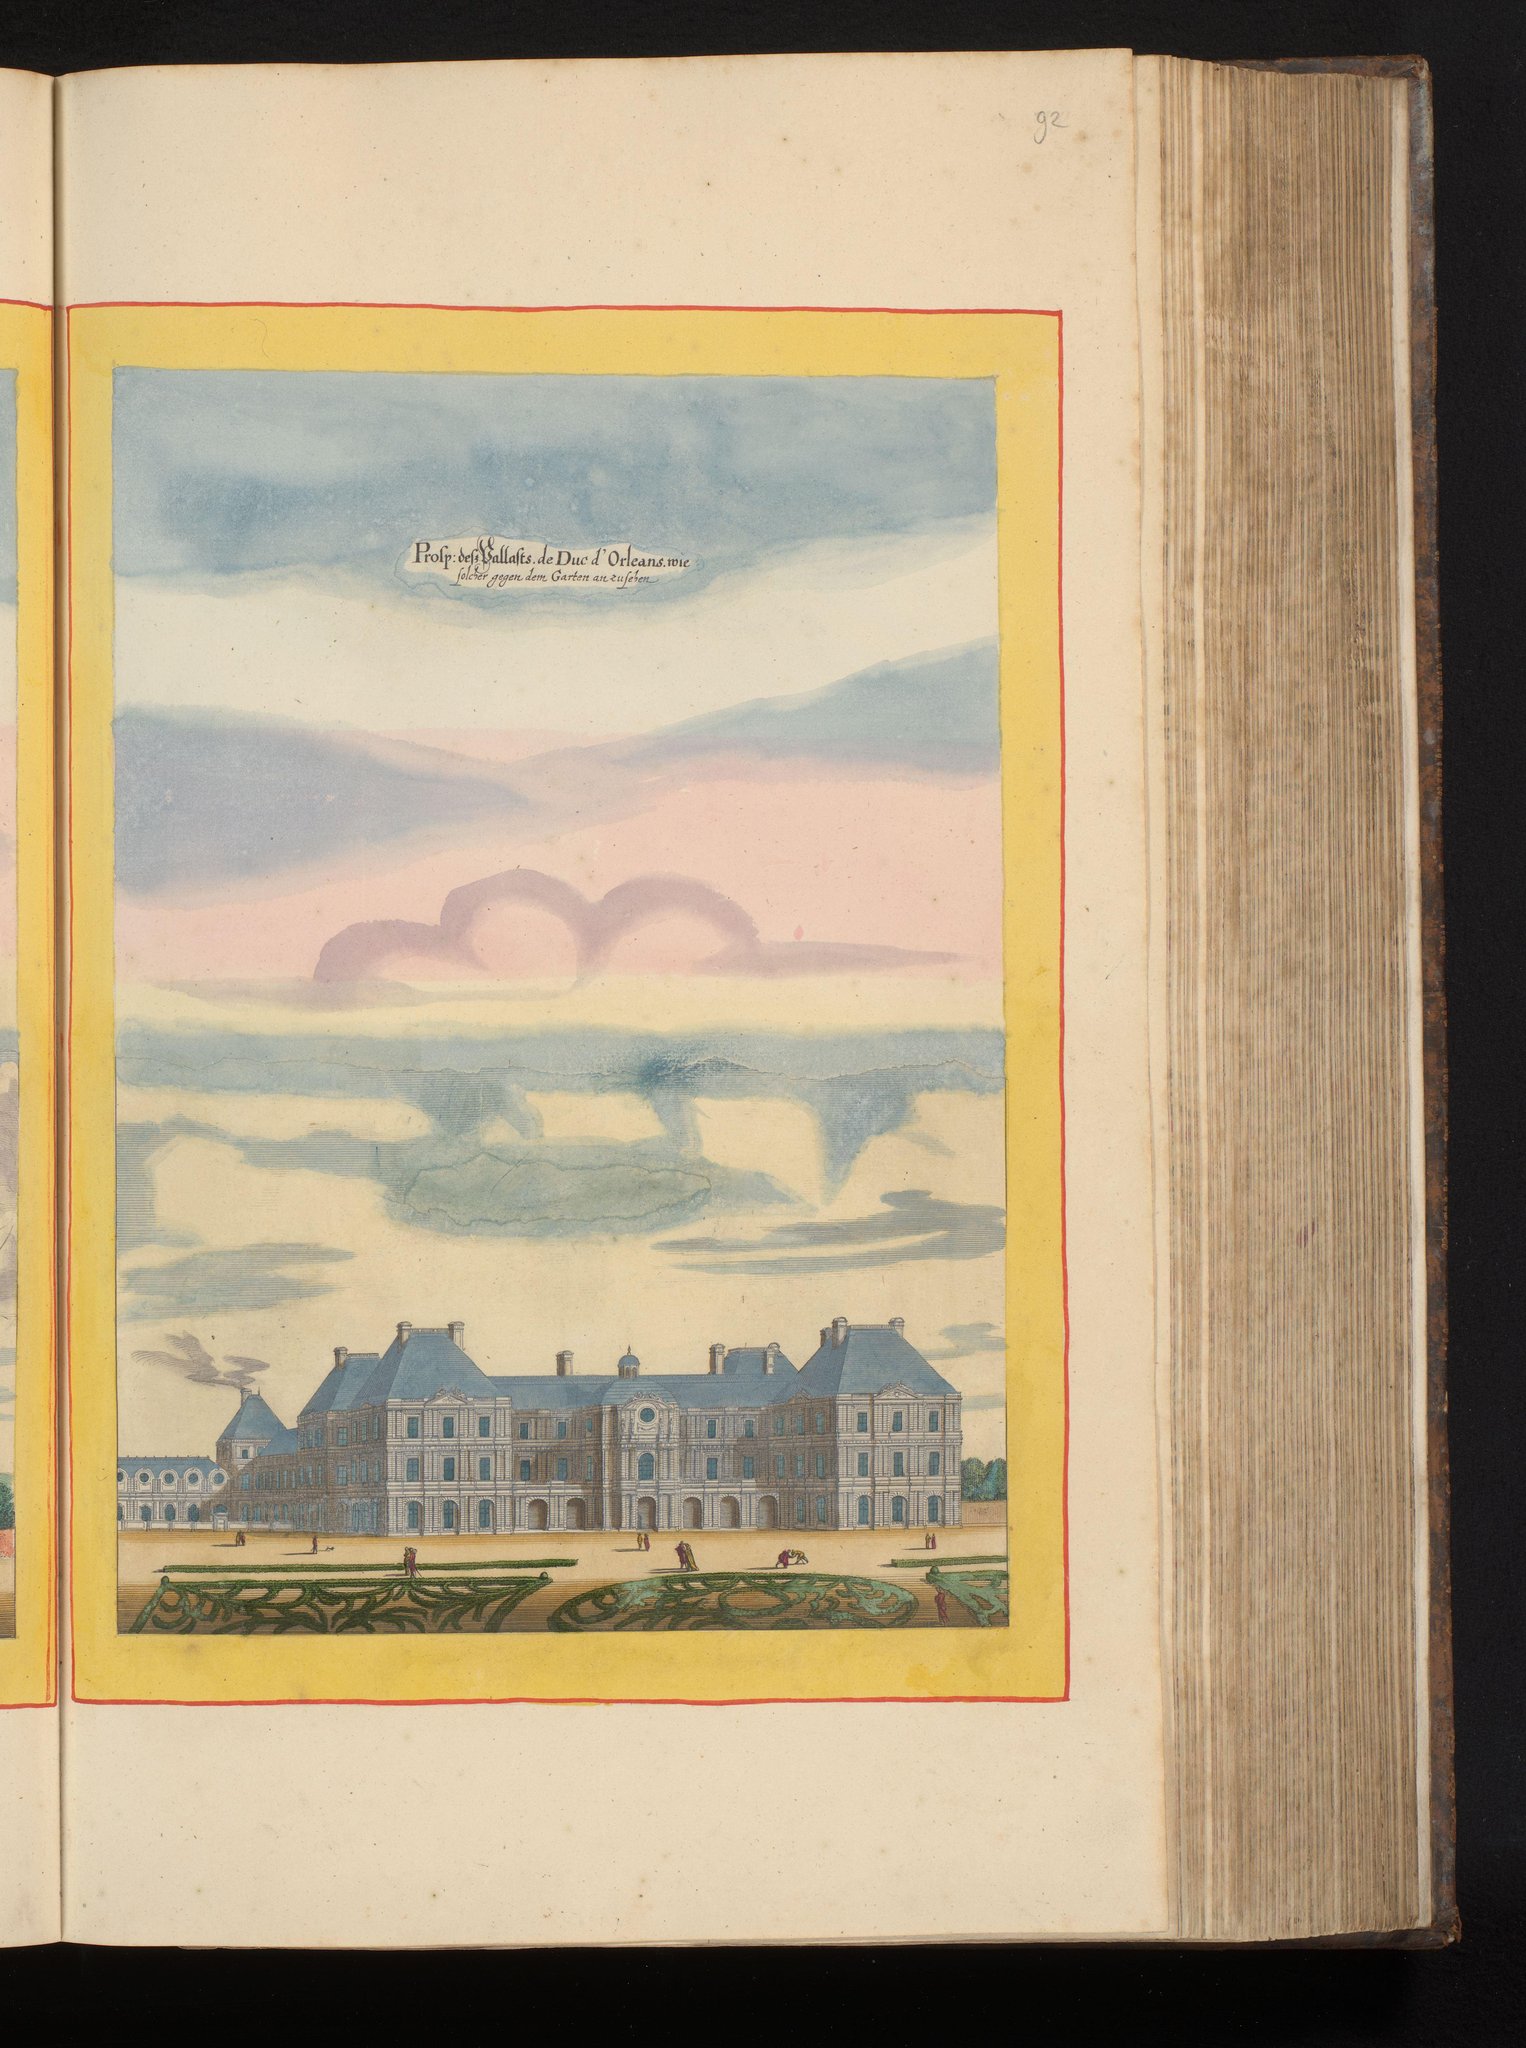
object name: album leaf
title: Prosp. dess Pallasts de Duc d'Orleans wie solcher gegen dem Garten an zusehen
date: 1655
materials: paper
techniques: engraving, etching, hand coloring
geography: frankfurt am main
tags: palace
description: Prent origineel vervaardigd als boekillustratie voor: Zeiller, Martin. Topographia Galliae, oder Beschreibung und Contrafaitung der vornehmbsten und bekantisten Oerter in dem mächtigen und grossen Königreich Frankreich, 13 delen. Frankfurt am Main: Caspar Merian, 1655-1661. De prent werd voor het eerst gepubliceerd in deel 1: Topographia Galliae, 1655. De prent is langs de bovenrand van de voorstelling afgescheurd. Het bovenste gedeelte is hoger opgeplakt, zodat de lucht hoger is geworden en het formaat van de voorstelling past bij de andere groot formaatvoorstellingen in het album. De voorstelling is aan de bovenzijde aangevuld met een geschilderde lucht.